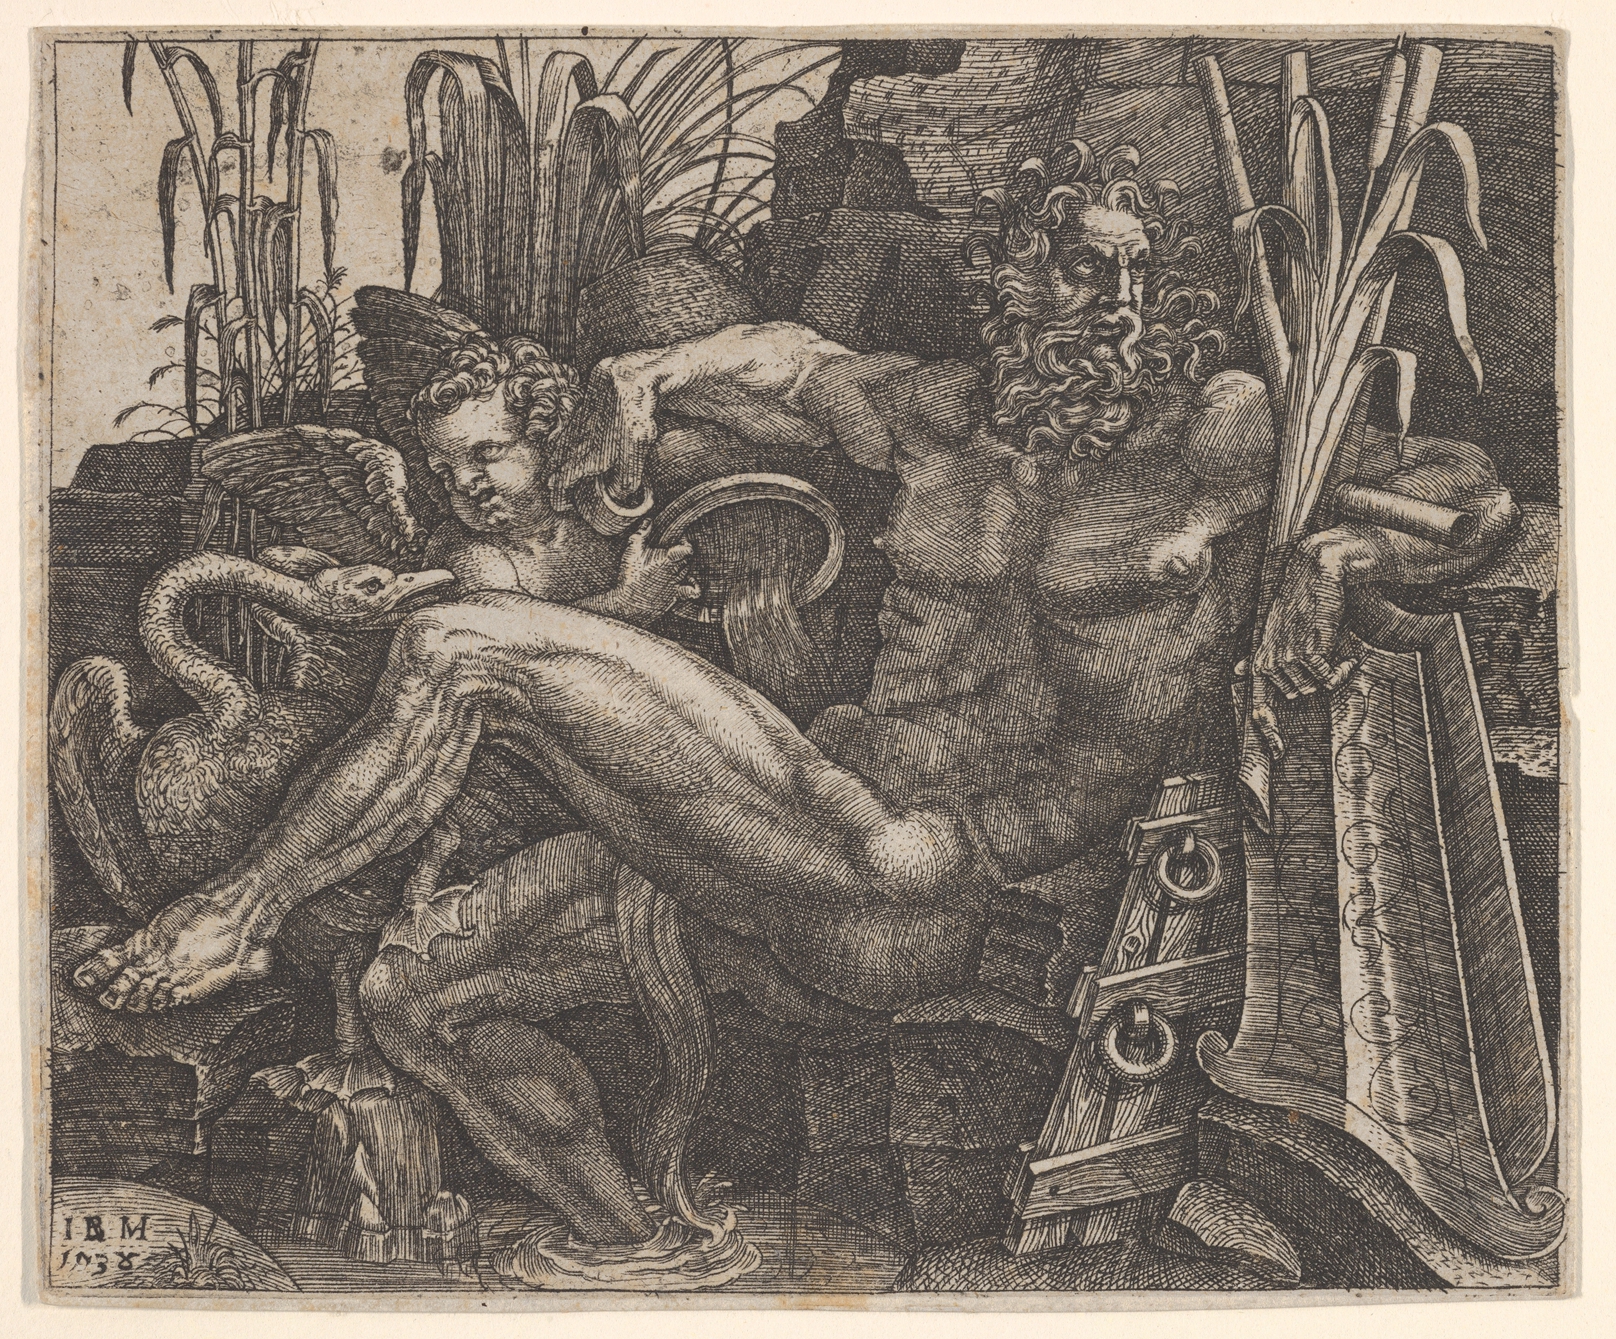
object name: print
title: River God Po reclining on a rocky bank, a winged putto and long-necked water bird stand behind his legs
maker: giovanni battista scultori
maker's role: artist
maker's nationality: italian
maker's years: 1503-1575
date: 1538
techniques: engraving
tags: birds,male nudes,putti